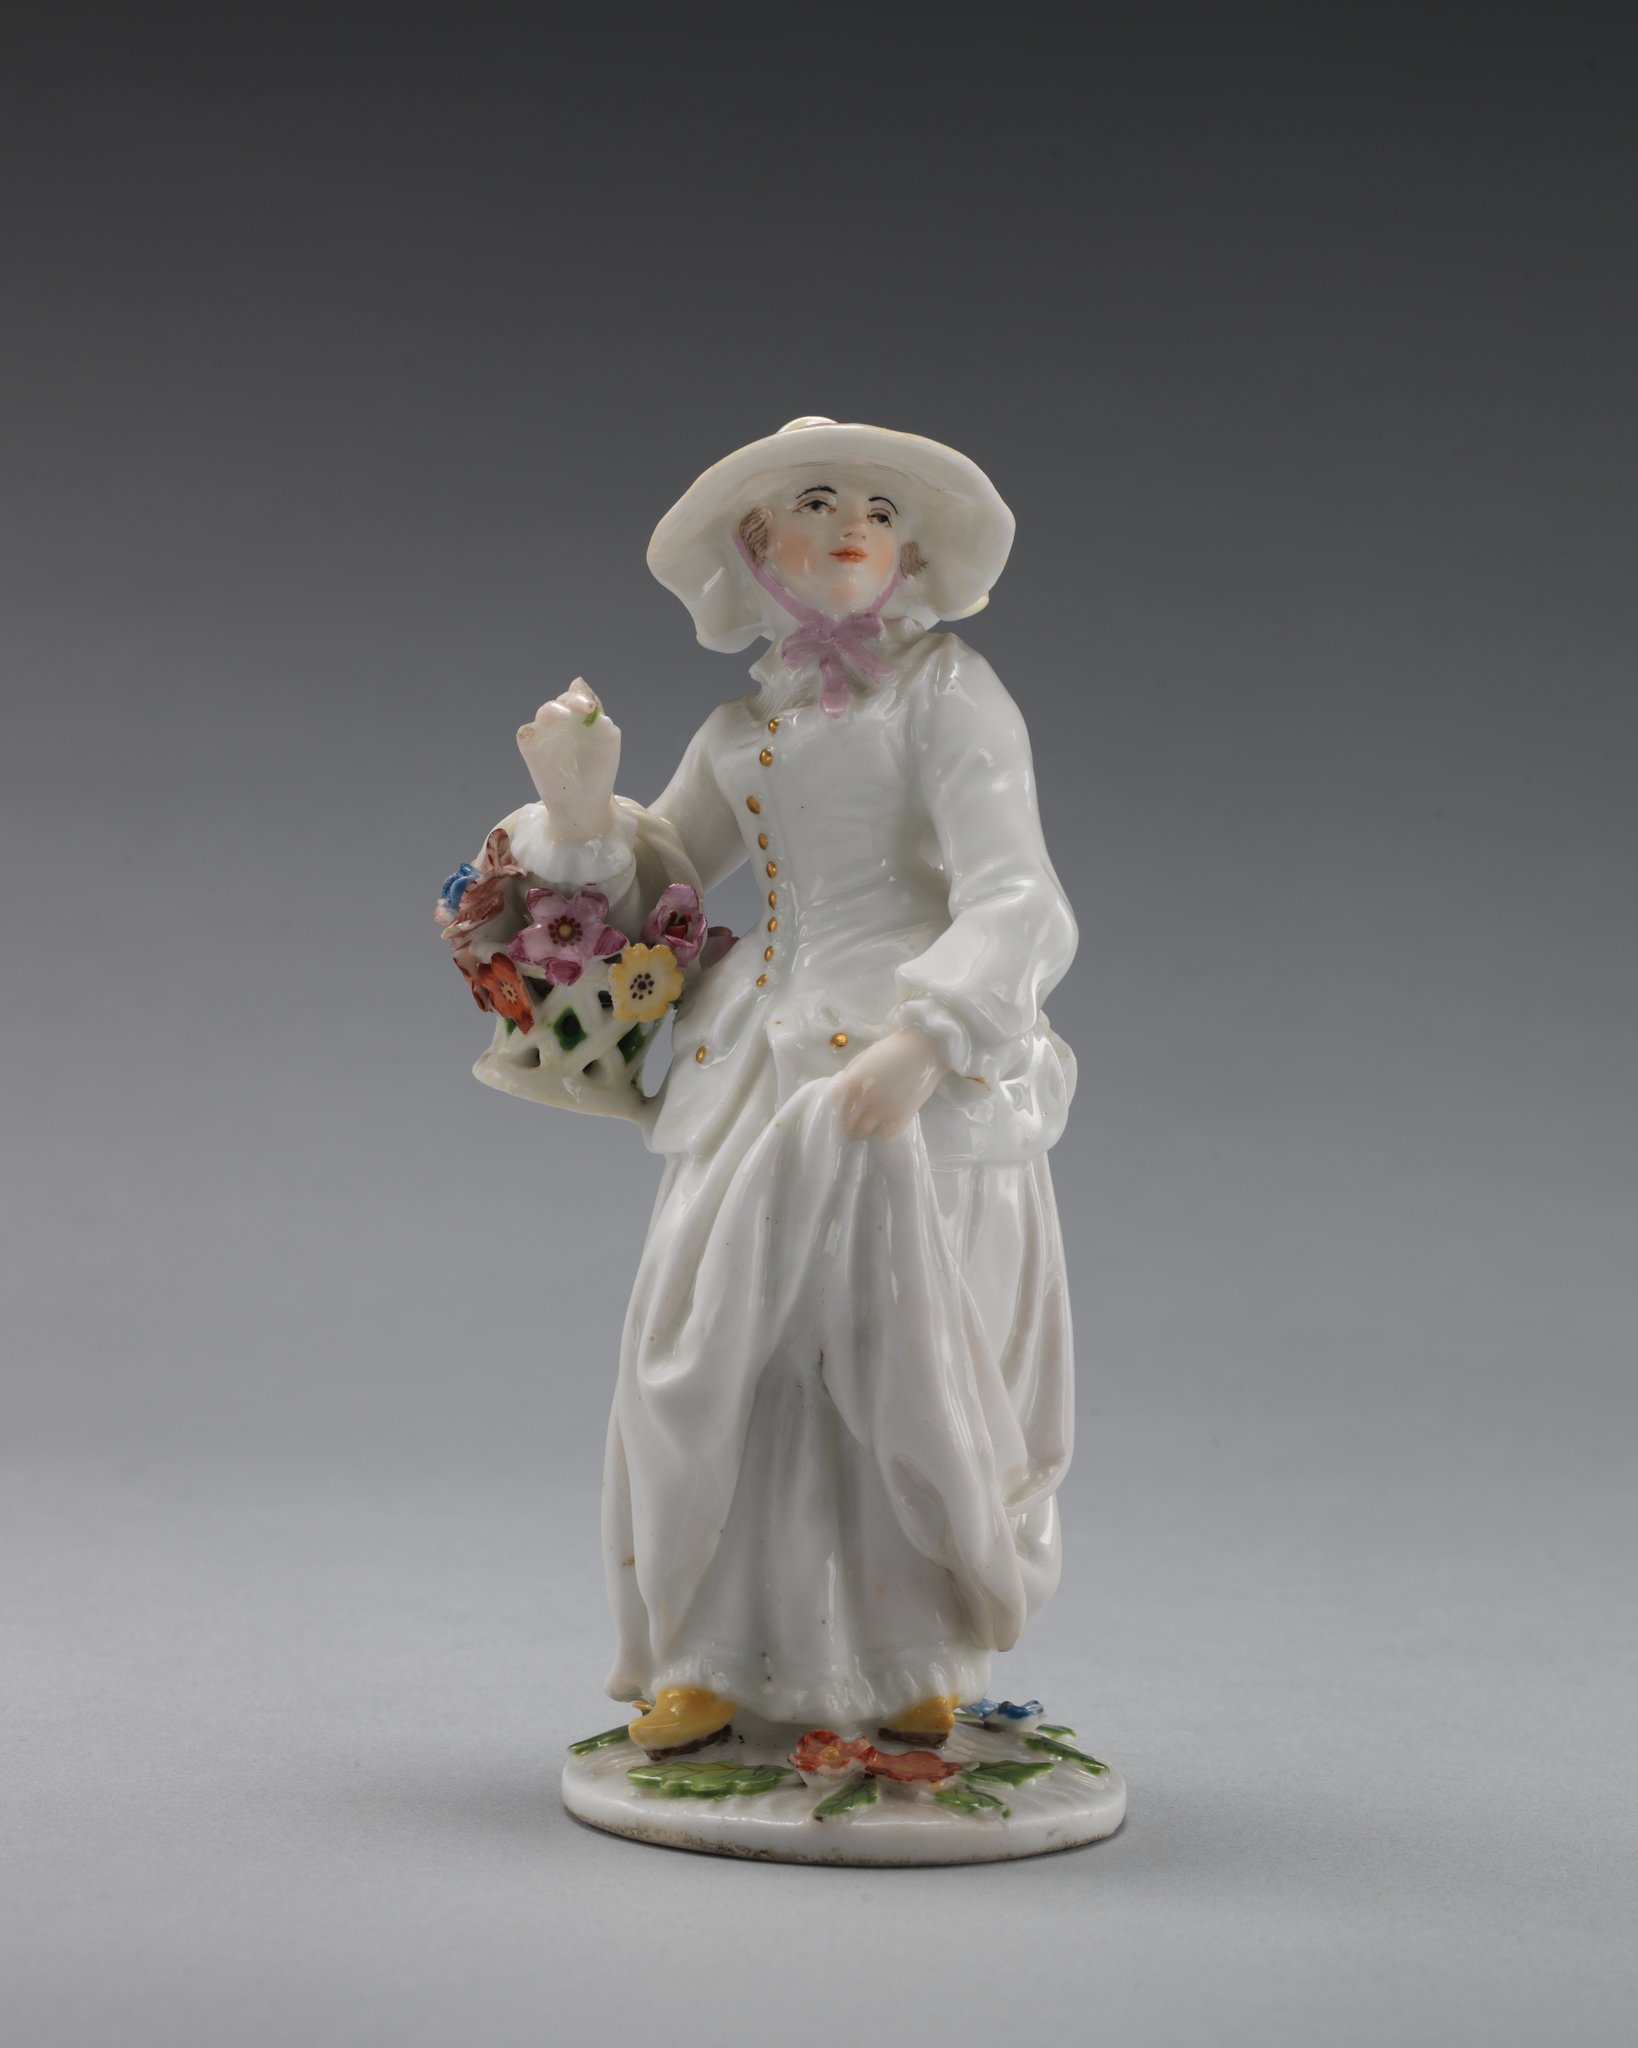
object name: figure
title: Four Seasons (Spring)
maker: chelsea porcelain manufactory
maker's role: factory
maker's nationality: british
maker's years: 1744-1784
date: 1753-1755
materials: soft paste porcelain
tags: women,flowers,leaves